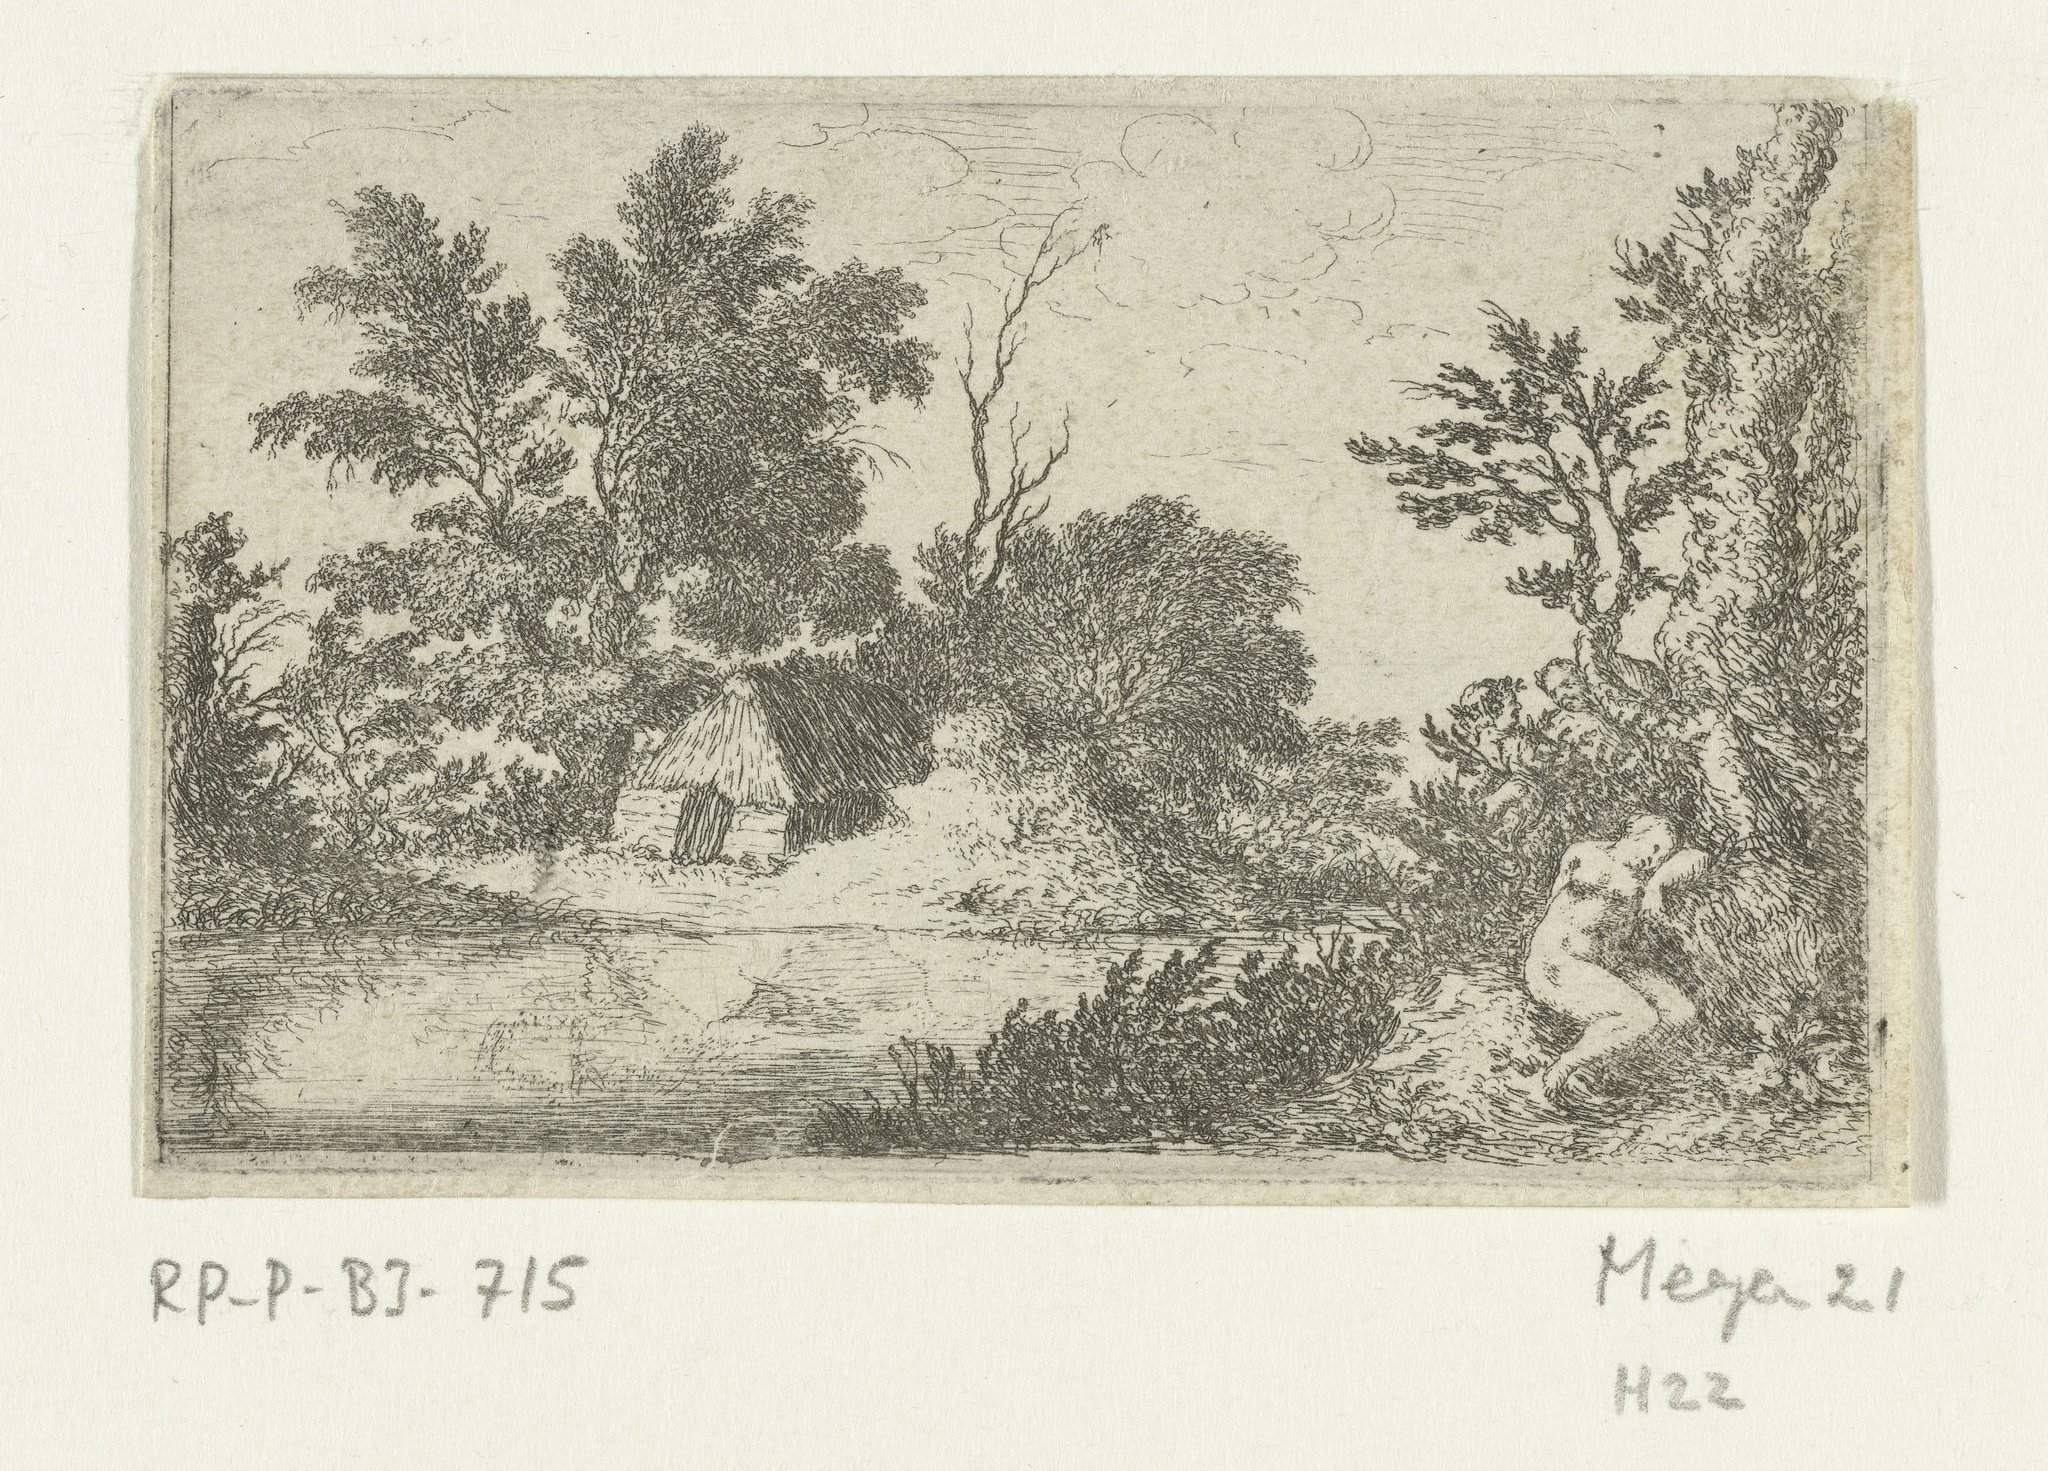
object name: print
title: Landschap met slapende nimf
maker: willem basse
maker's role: draughtsman, print maker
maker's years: 1613-1672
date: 1633-1672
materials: paper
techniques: etching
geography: amsterdam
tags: satyr(s) pursuing nymph(s), sleeping; unconsciousness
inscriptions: collector's mark: Lugt 2228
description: Landschap met rechts een slapende nimf die bespied wordt door twee saters die achter haar in de bosjes staan.